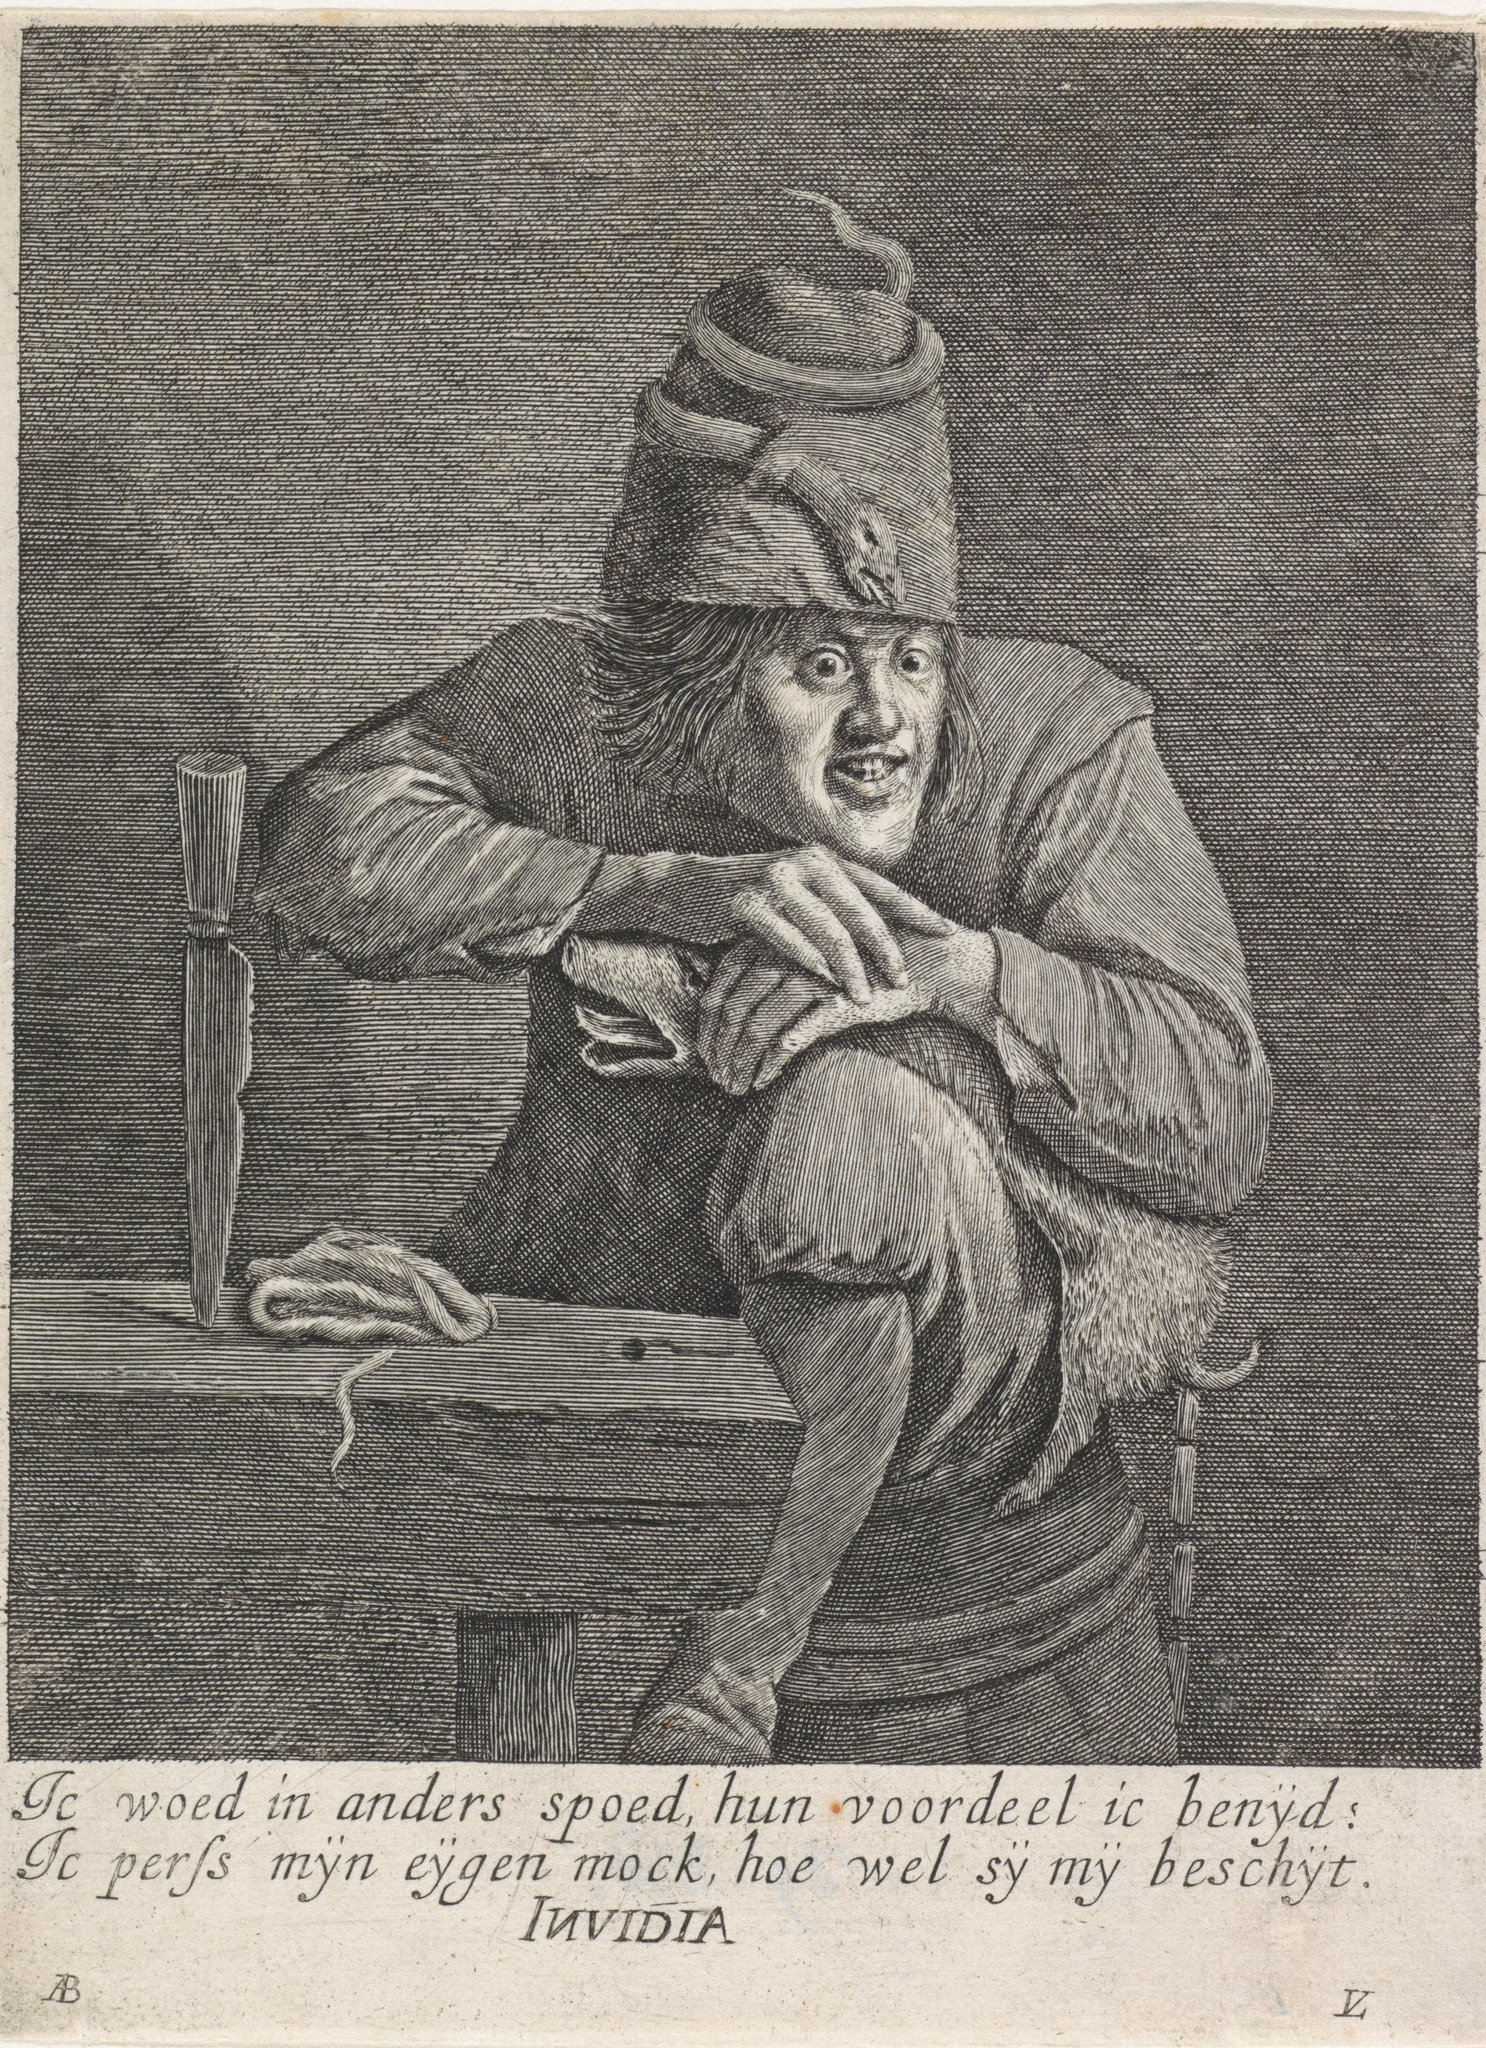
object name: print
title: Afgunst (Invidia)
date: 1619-1675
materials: paper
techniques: engraving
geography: antwerp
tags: envy; 'invidia' (ripa) ~ personification of one of the seven deadly sins, piglet, suckling pig, tools, aids, implements ~ crafts and industries: knife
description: Een arme man, met een slang om zijn muts, zit op een ton en perst een big uit, die poept. Voor hem is een mes in het tafelblad gestoken.